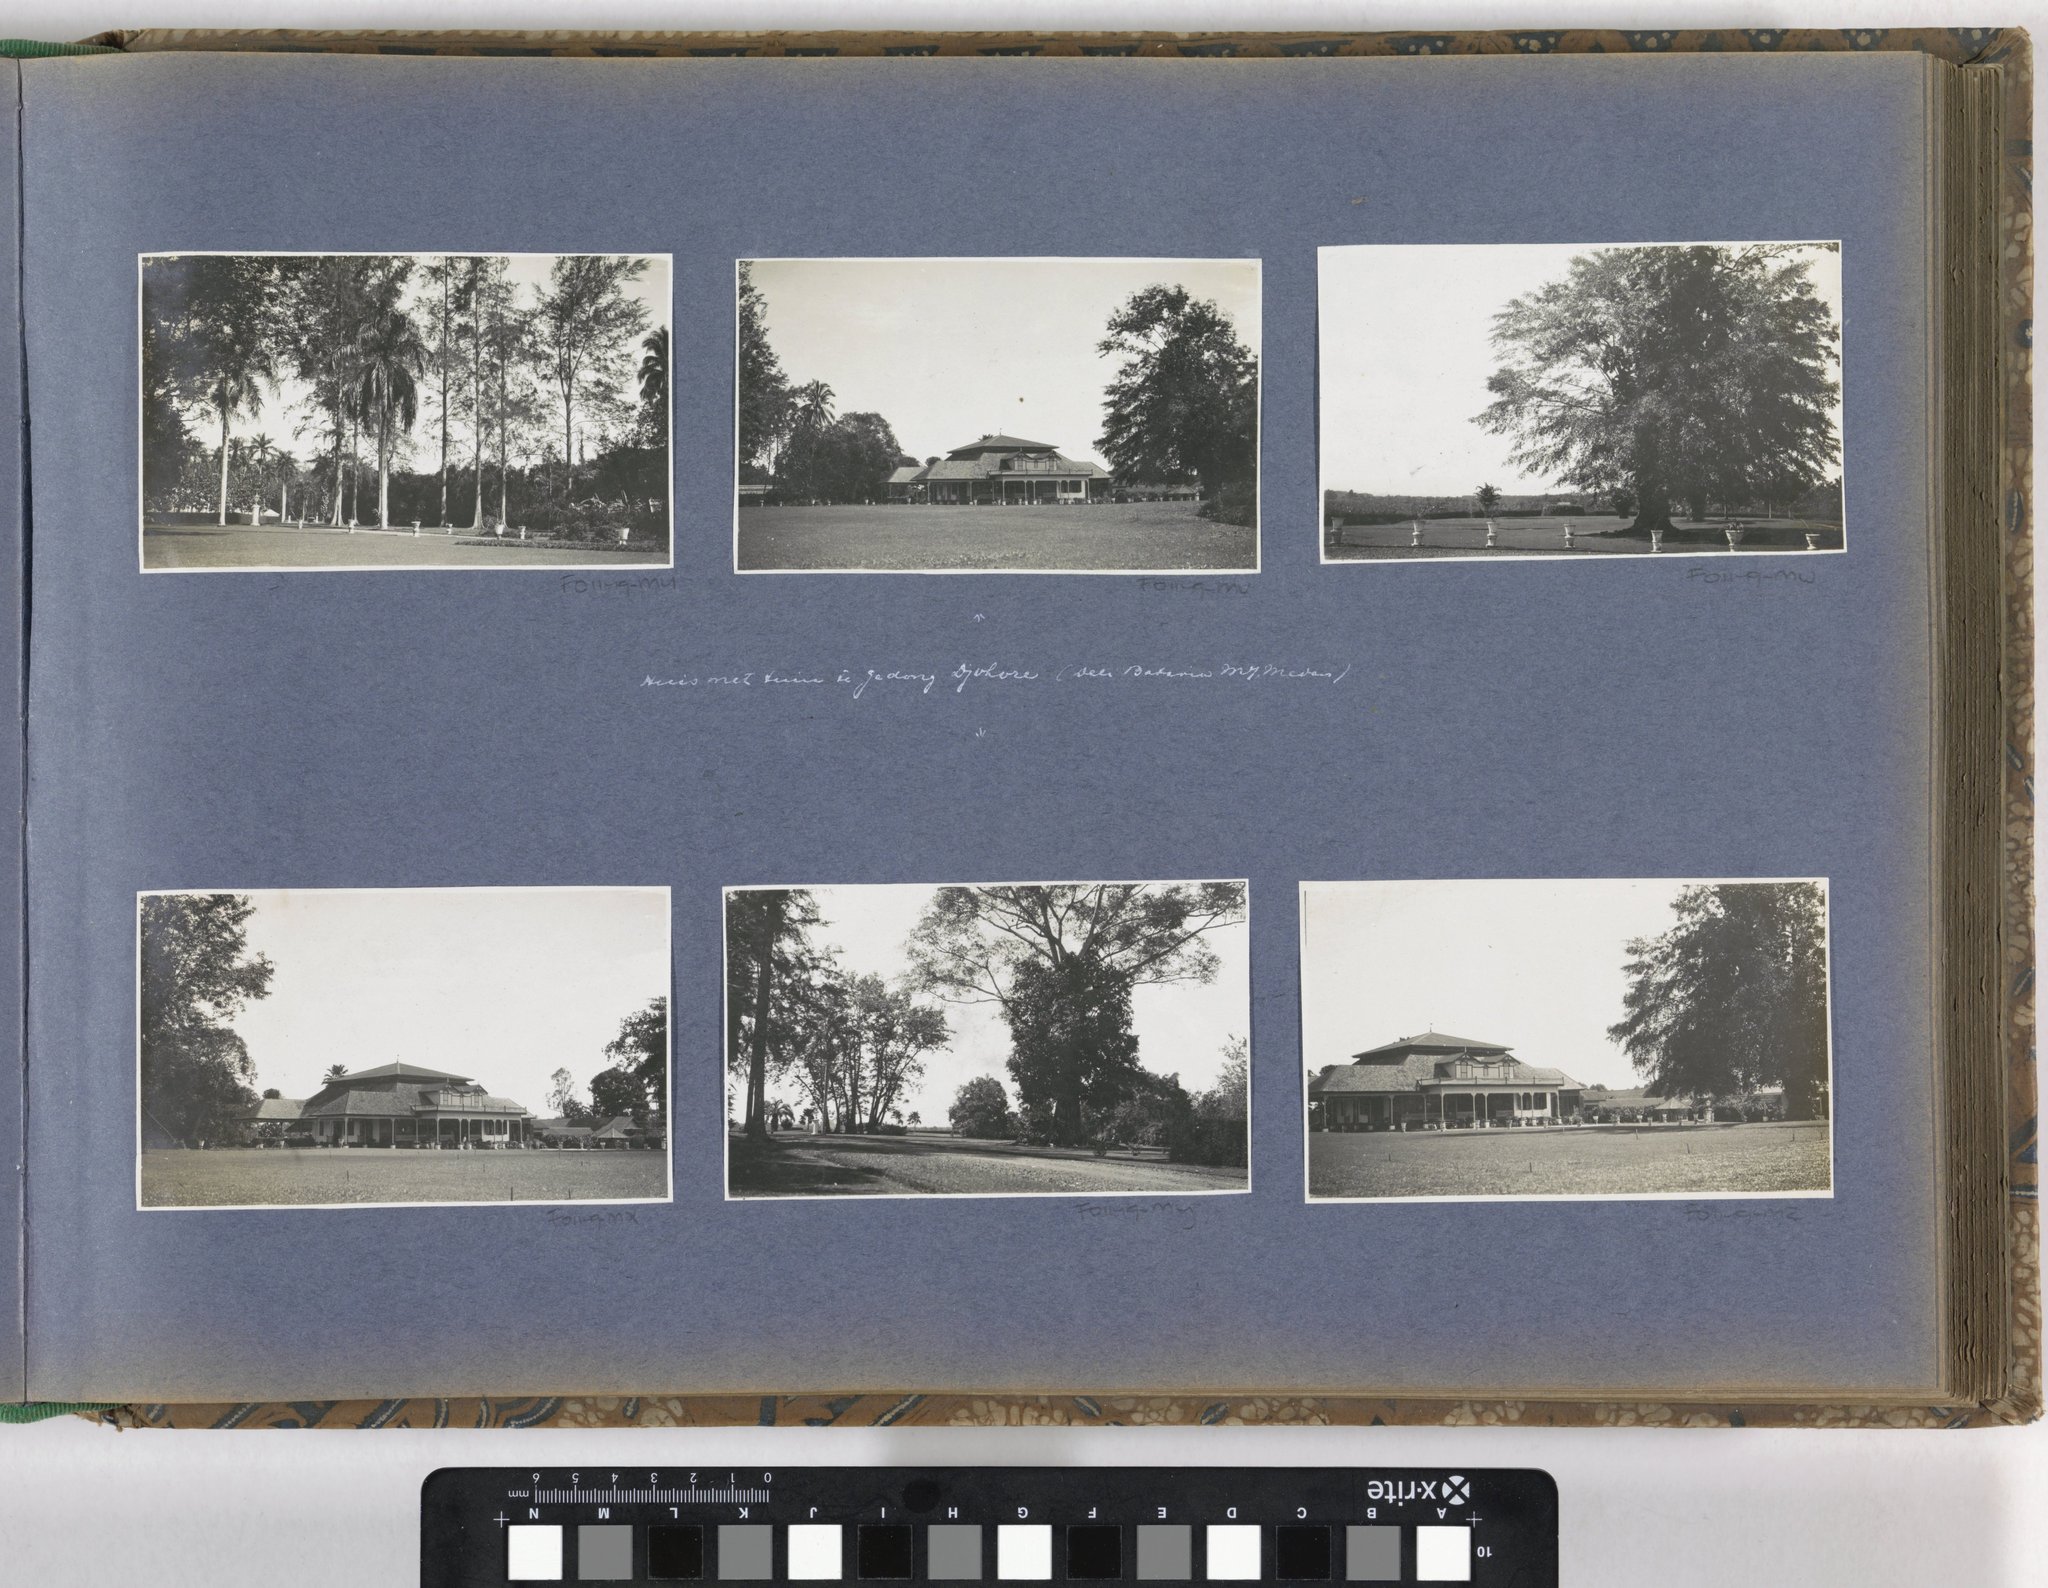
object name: photograph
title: Huis met tuin van cultuuronderneming Gedong Djohore van de Deli-Batavia Maatschappij bij Medan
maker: Anonymous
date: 1900-1920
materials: paper, photographic support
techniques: gelatin silver print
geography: sumatra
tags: plantation, garden, rural housing, e.g. country-house, villa, cottage, sumatra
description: Onderdeel van reisalbum met foto's van bedrijvigheid en bezienswaardigheden op Sumatra en Java en van de reis naar en van Nederlands-Indië.